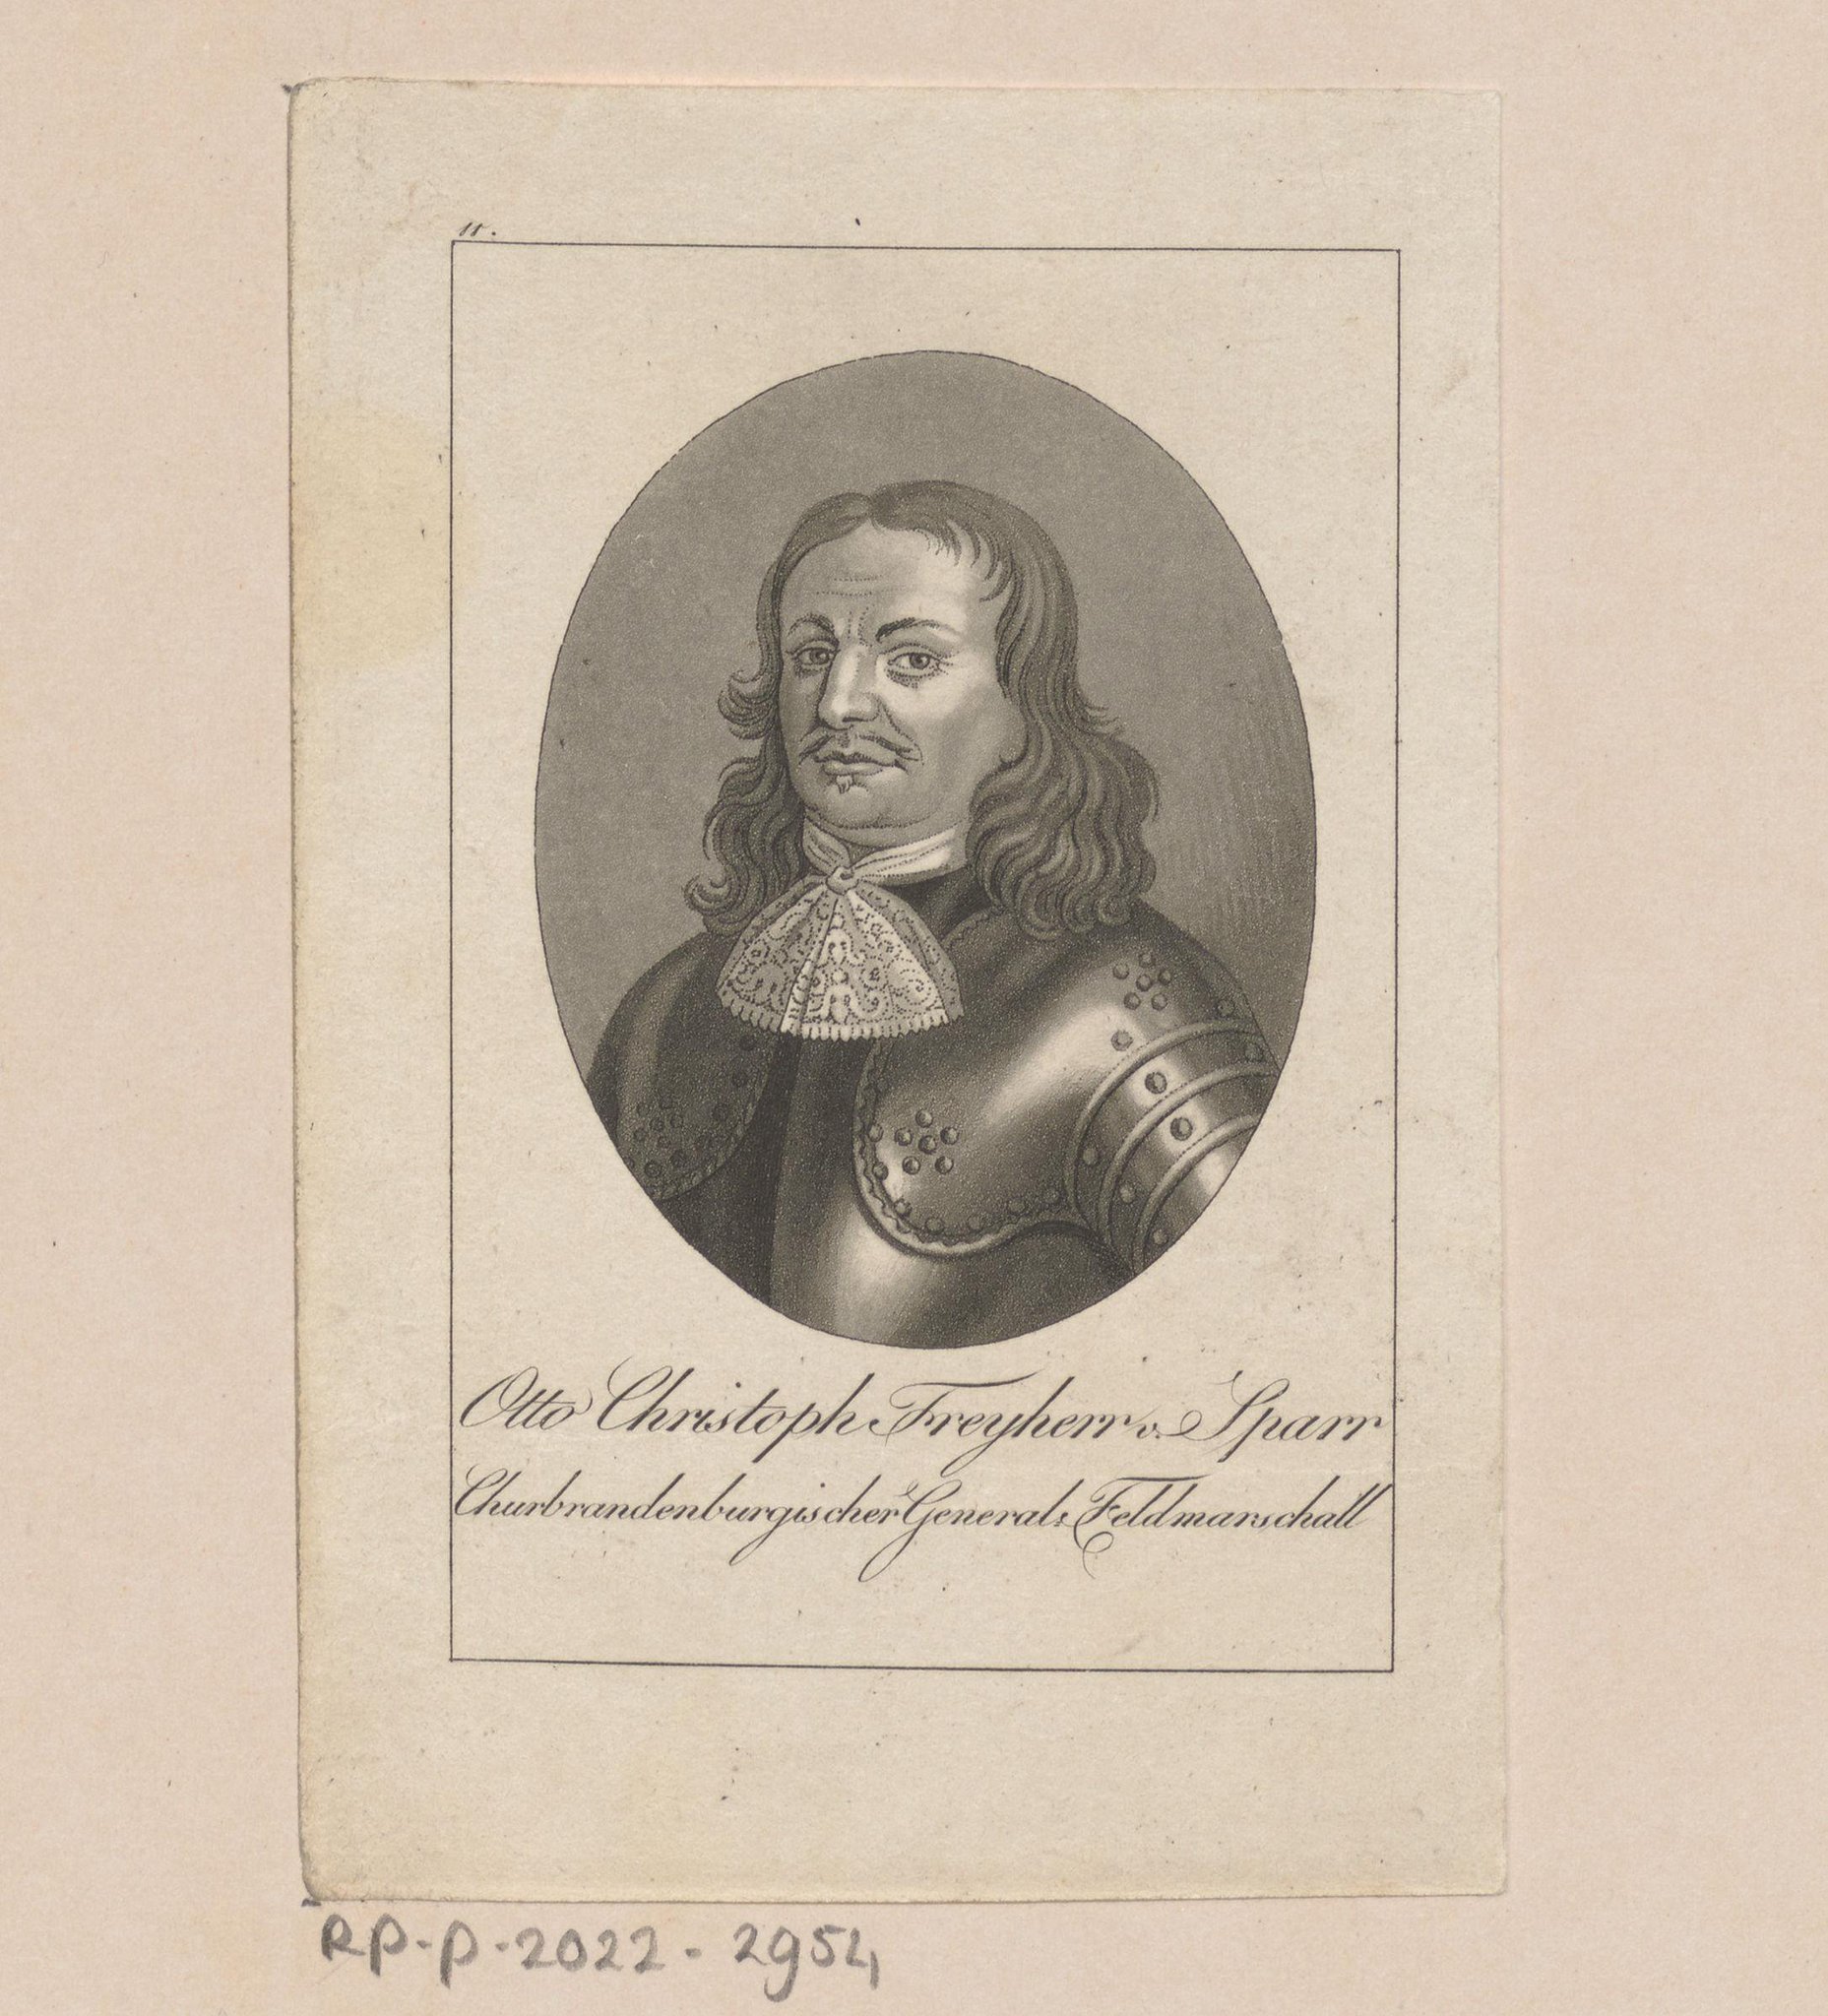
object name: print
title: Portret van Otto Christoph van Sparr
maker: Anonymous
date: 1700-1799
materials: paper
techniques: aquatint, etching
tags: other sovereign (baron), commander-in-chief, general, marshal, historical persons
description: Met tweeregelig onderschrift in het Duits.